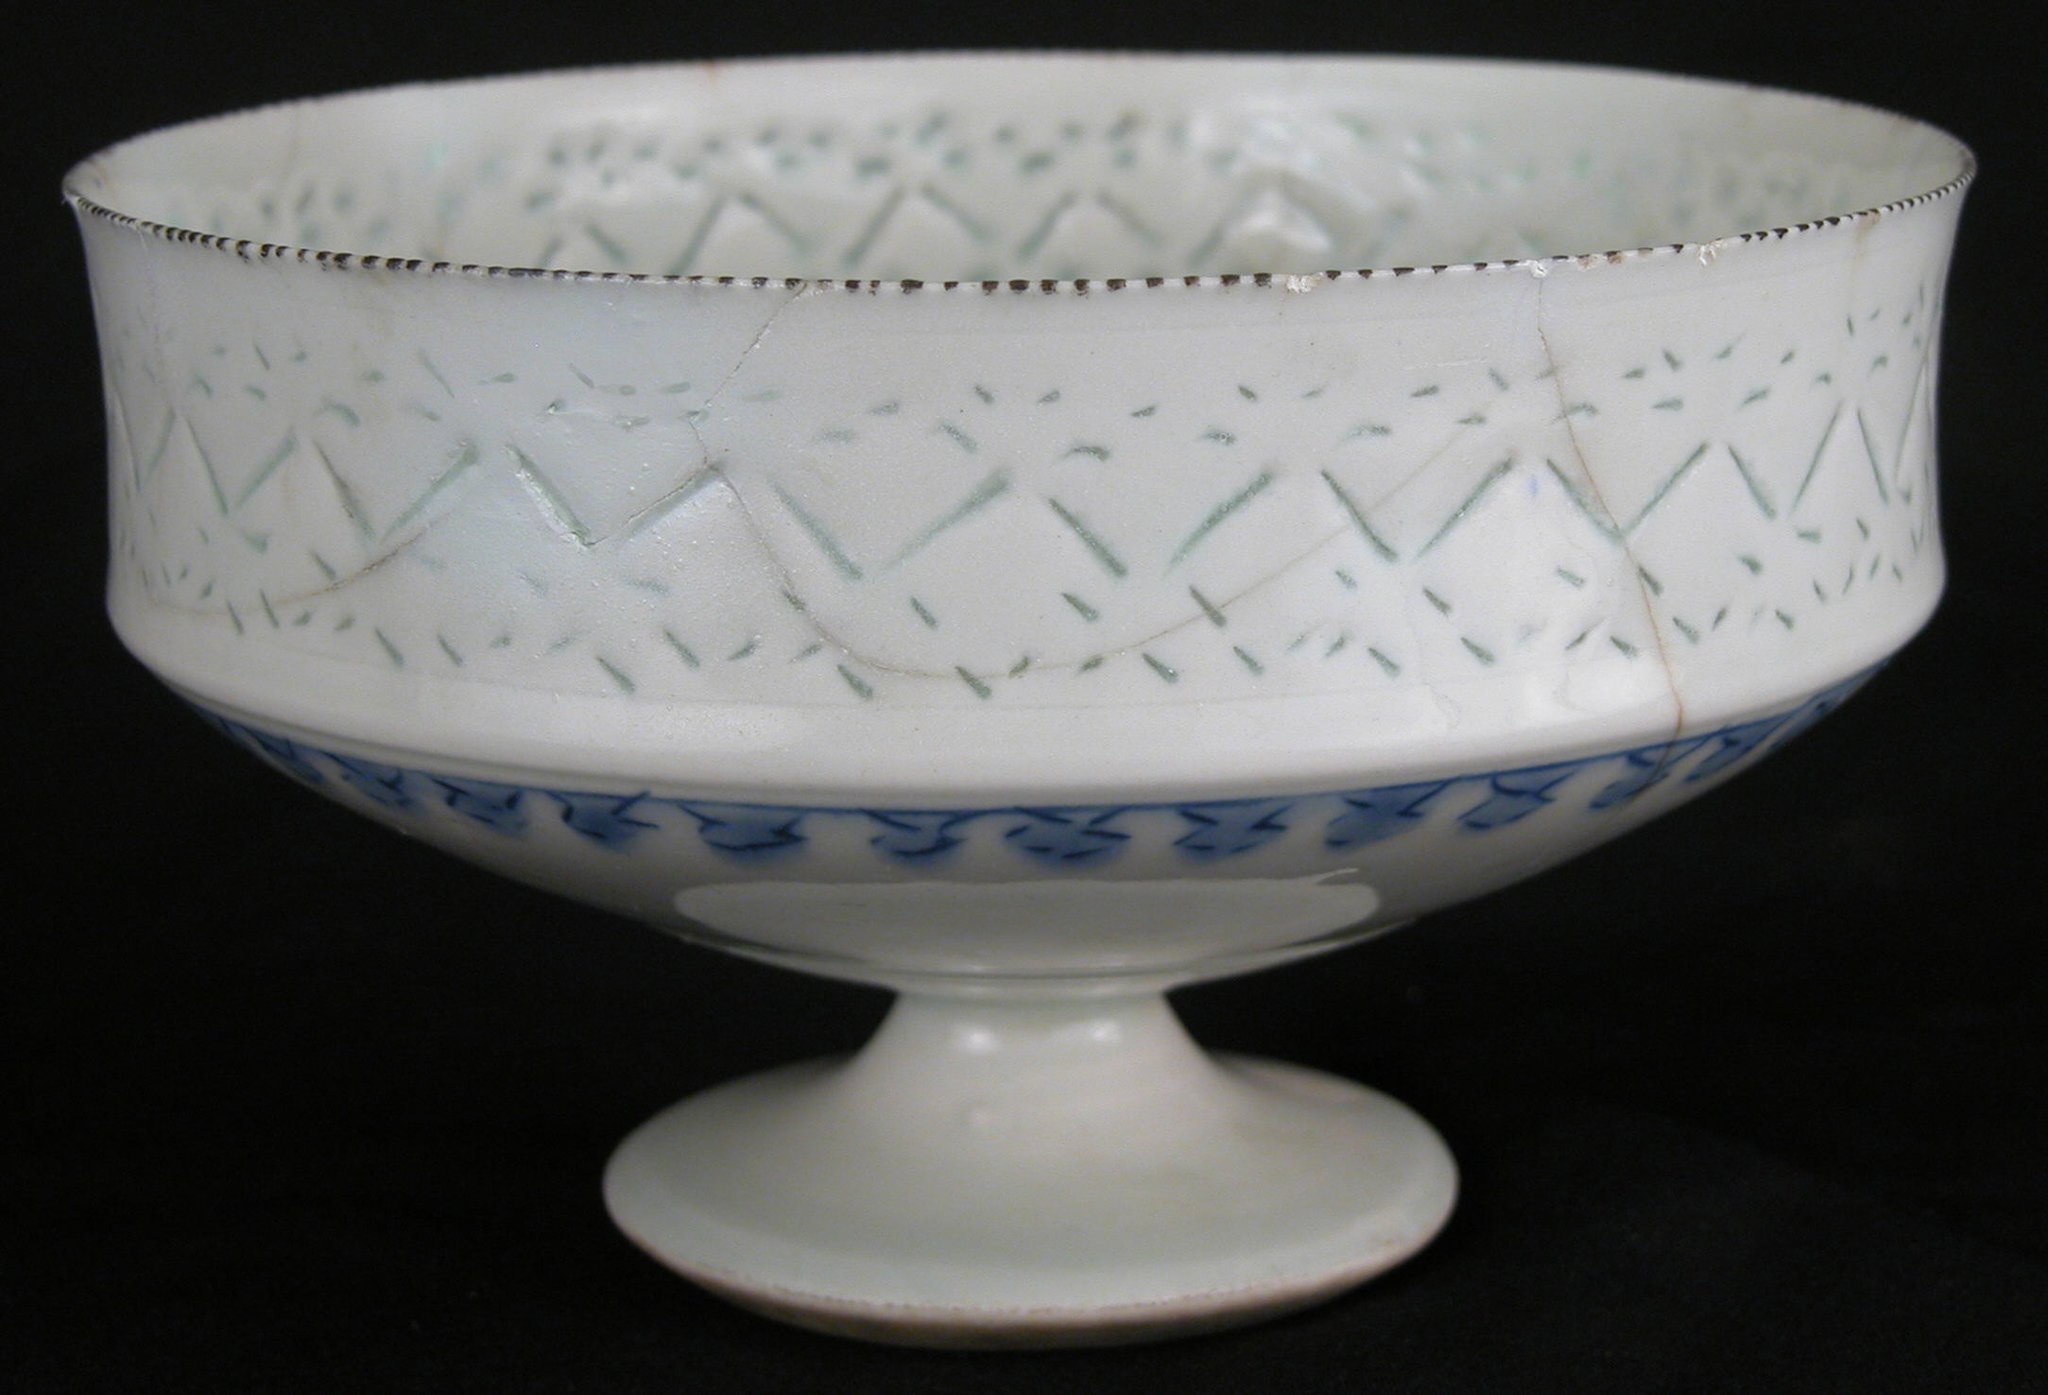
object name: dish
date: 1701-1750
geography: iran